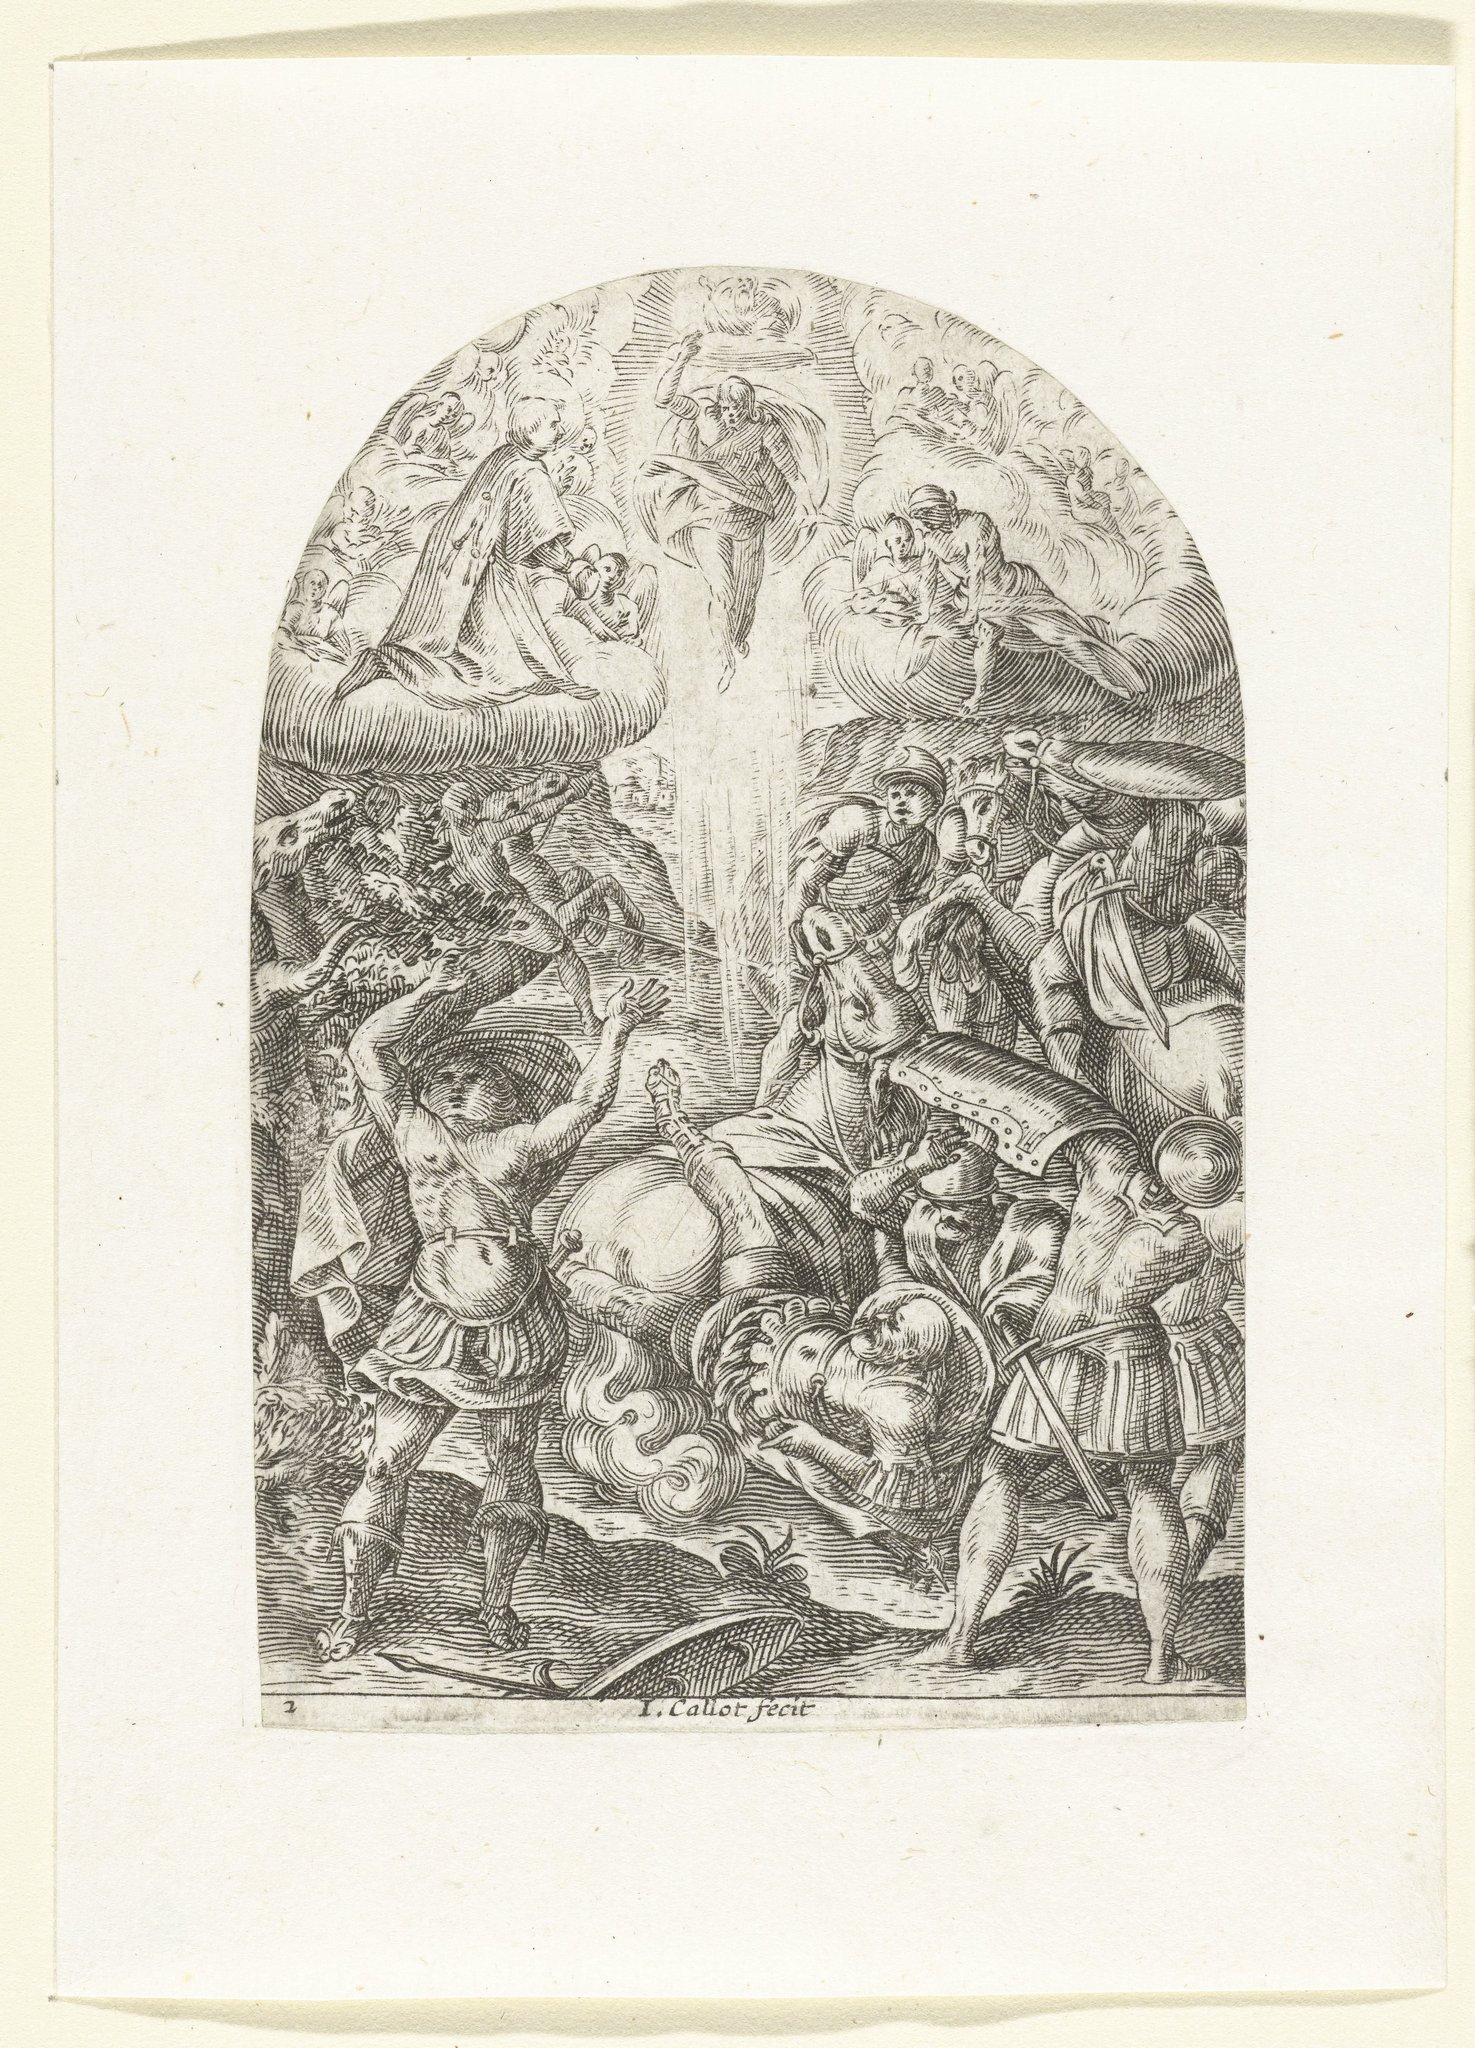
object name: print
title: De bekering van Paulus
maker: jacques callot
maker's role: draughtsman, print maker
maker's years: 1592-1635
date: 1608-1611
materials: paper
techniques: engraving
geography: rome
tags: on the way to damascus christ appears to saul, who falls from his horse and is blinded by the light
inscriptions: collector's mark: Lugt 240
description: Paulus valt van zijn paard als Christus in een groot licht aan de hemel verschijnt. Deze prent is onderdeel van (de tweede staat van) een serie van 29 voorstellingen van schilderijen en sculpturen in kerken te Rome, genummerd 1-16 en 1-13. (De eerste staat van deze serie, waarin de prenten ongenummerd zijn, behelst ook een titelprent).